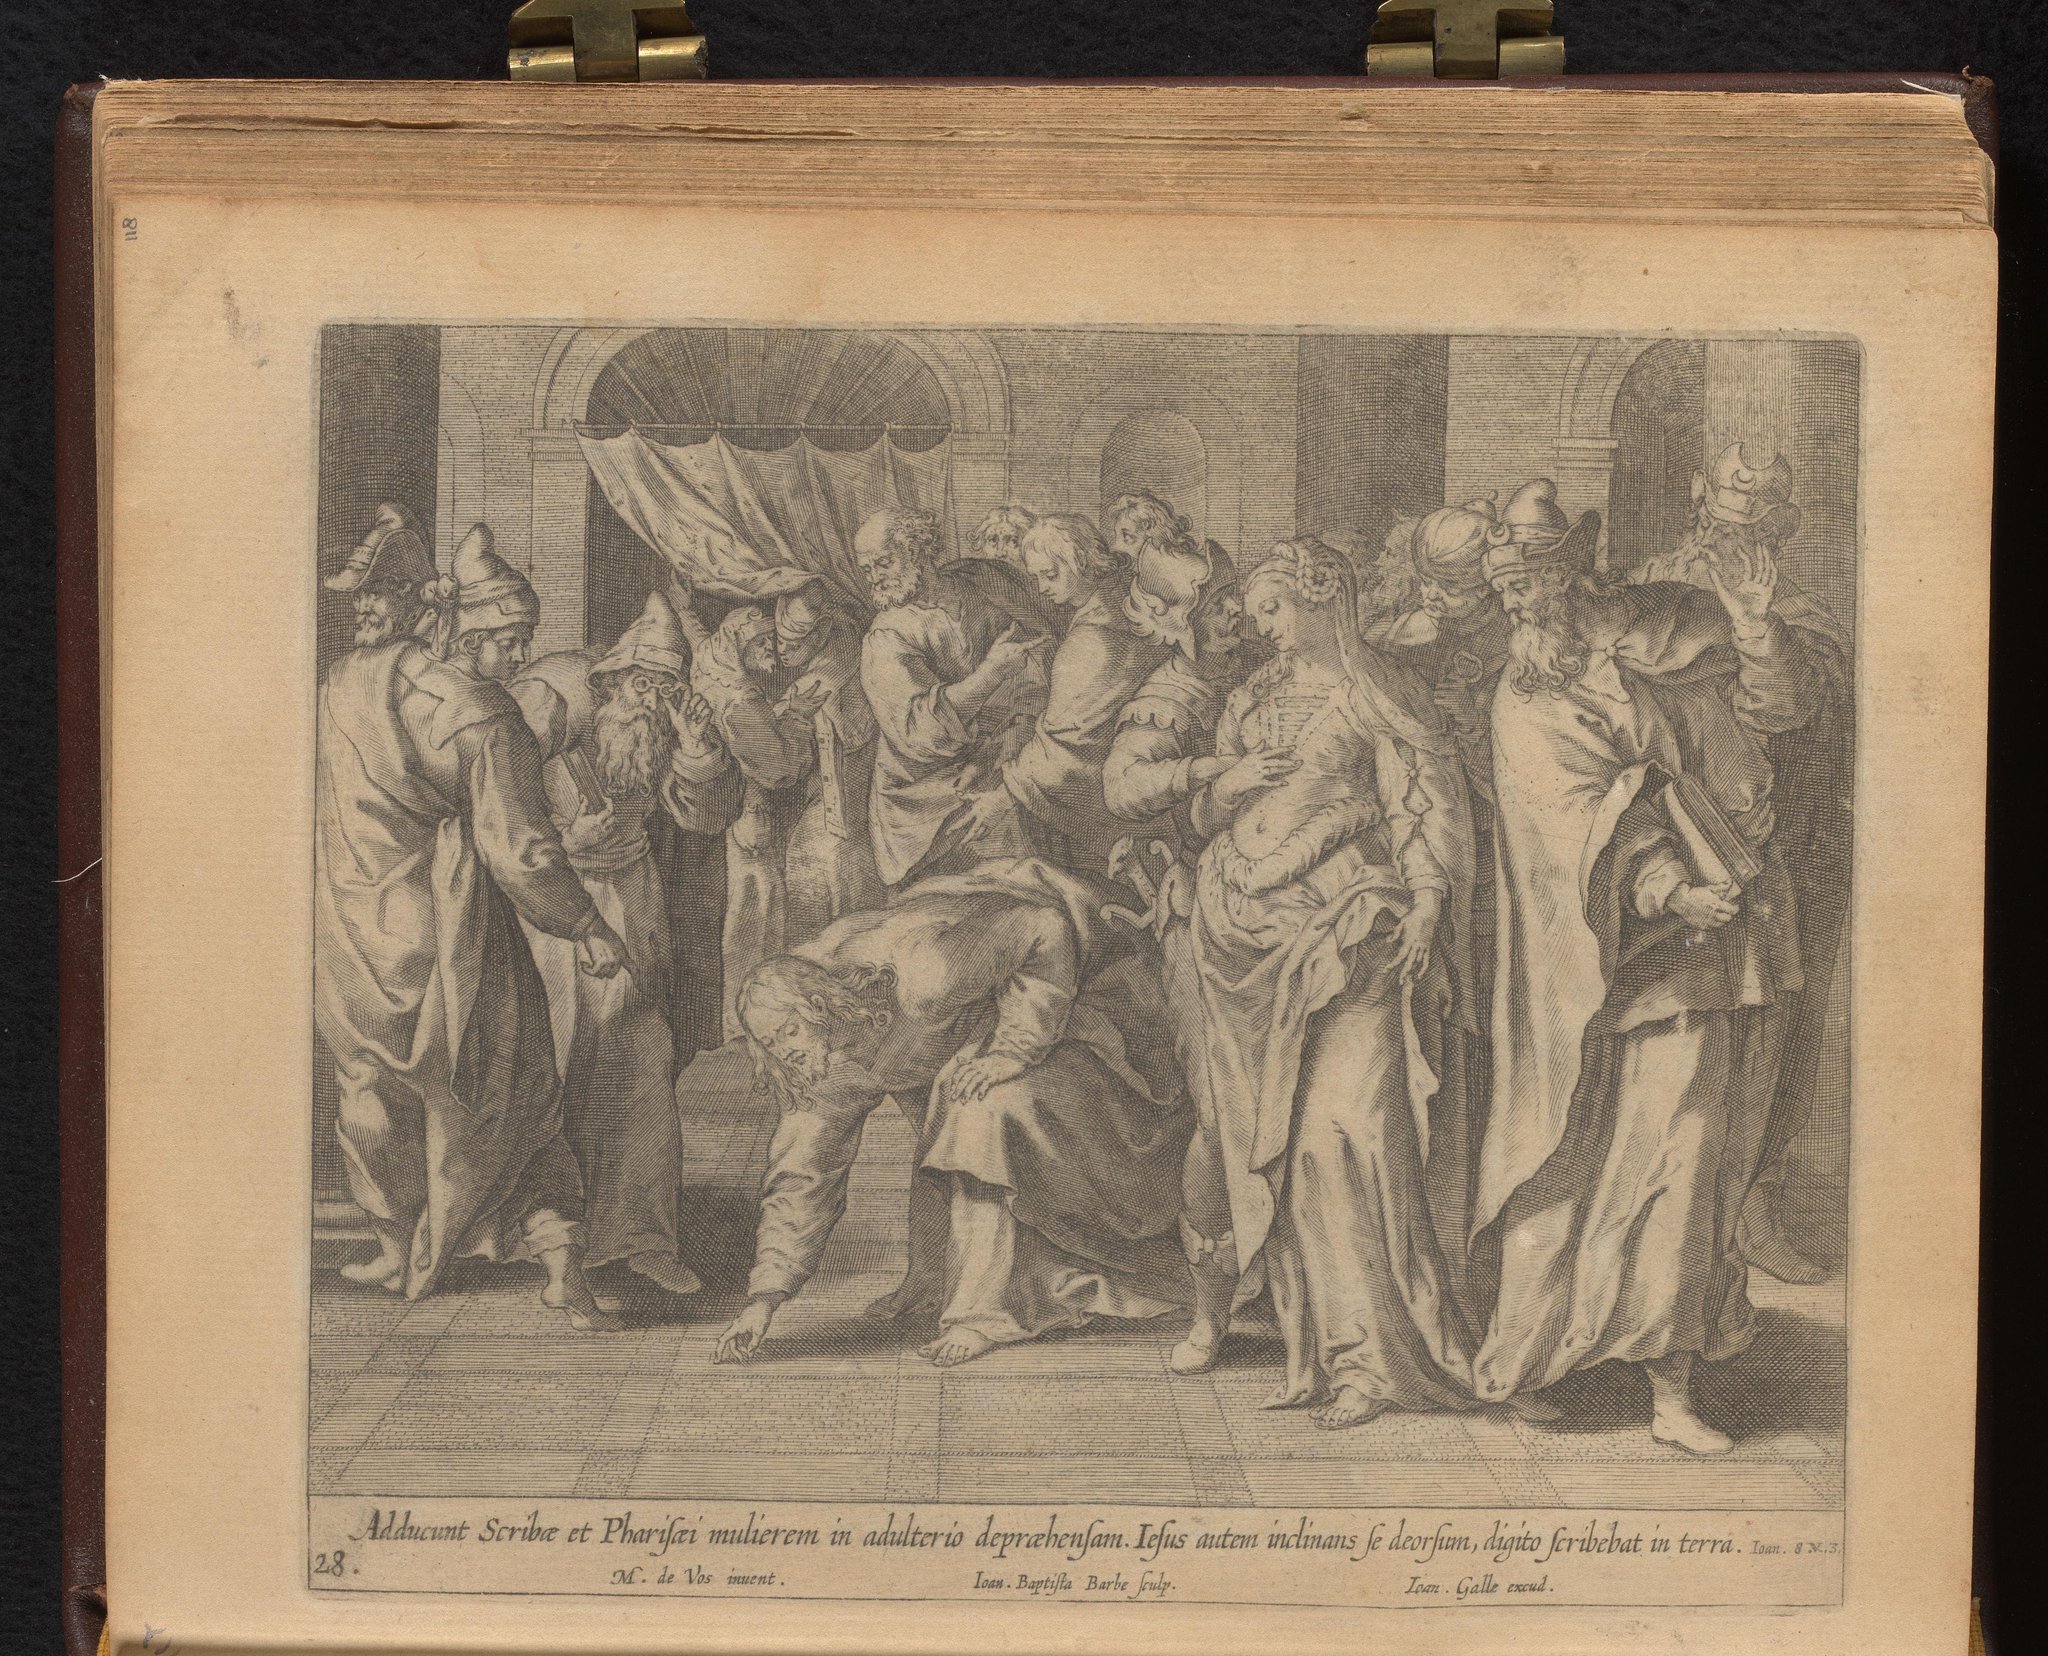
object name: print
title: Vita, passio et Resvrrectio Iesv Christi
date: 1598-1618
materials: paper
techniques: engraving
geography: antwerp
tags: christ points to or writes on the ground, pharisees bring a woman accused of adultery before christ (john 8:2-11)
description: Prent maakt deel uit van een prentbijbel.